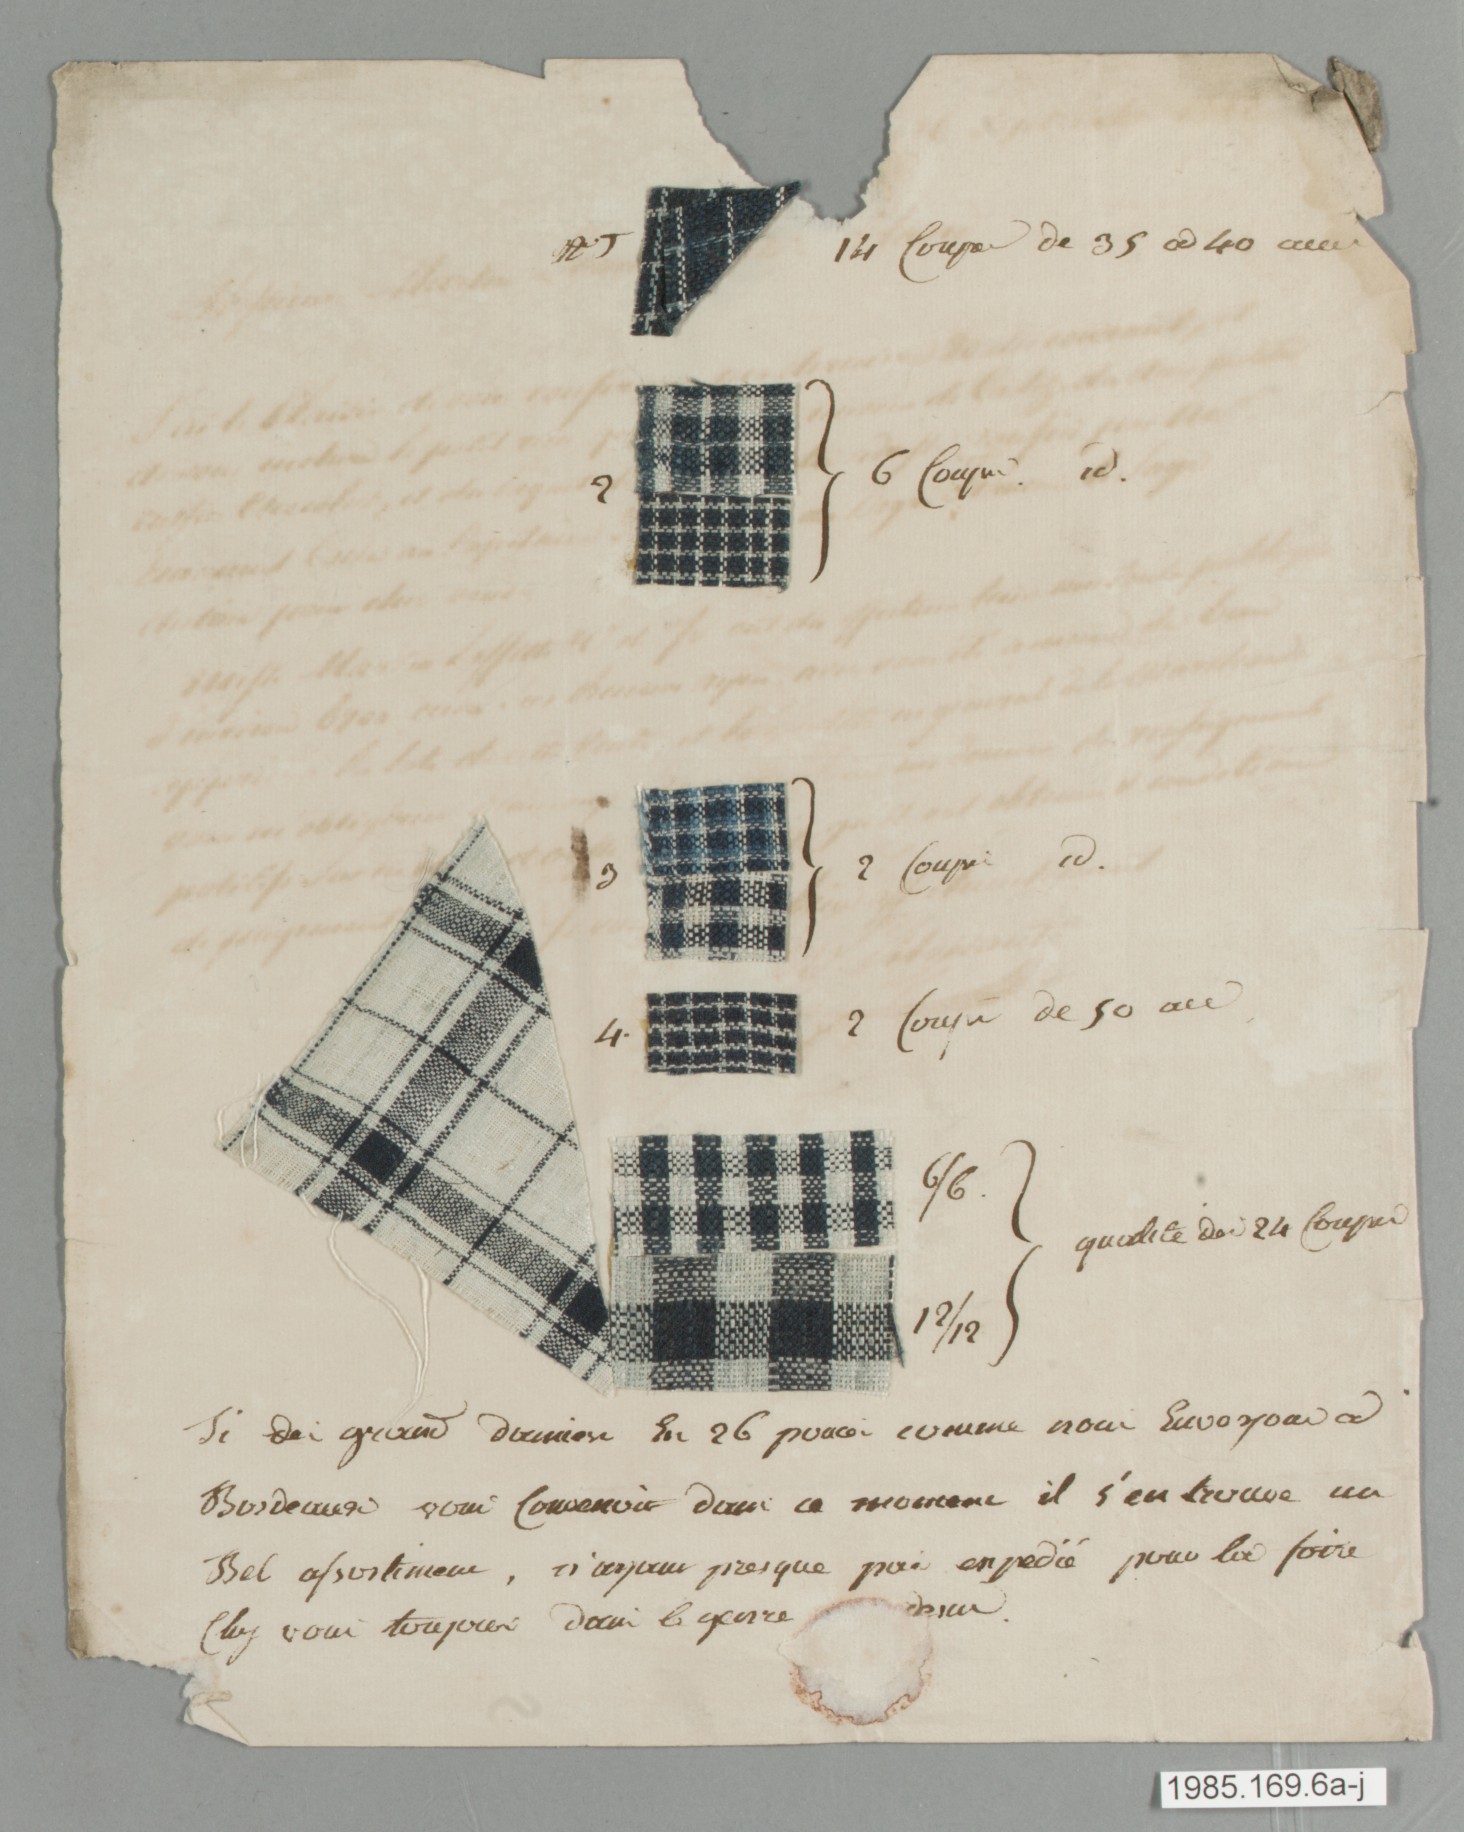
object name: letter with textile sample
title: Letter with textile samples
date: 1767-1833